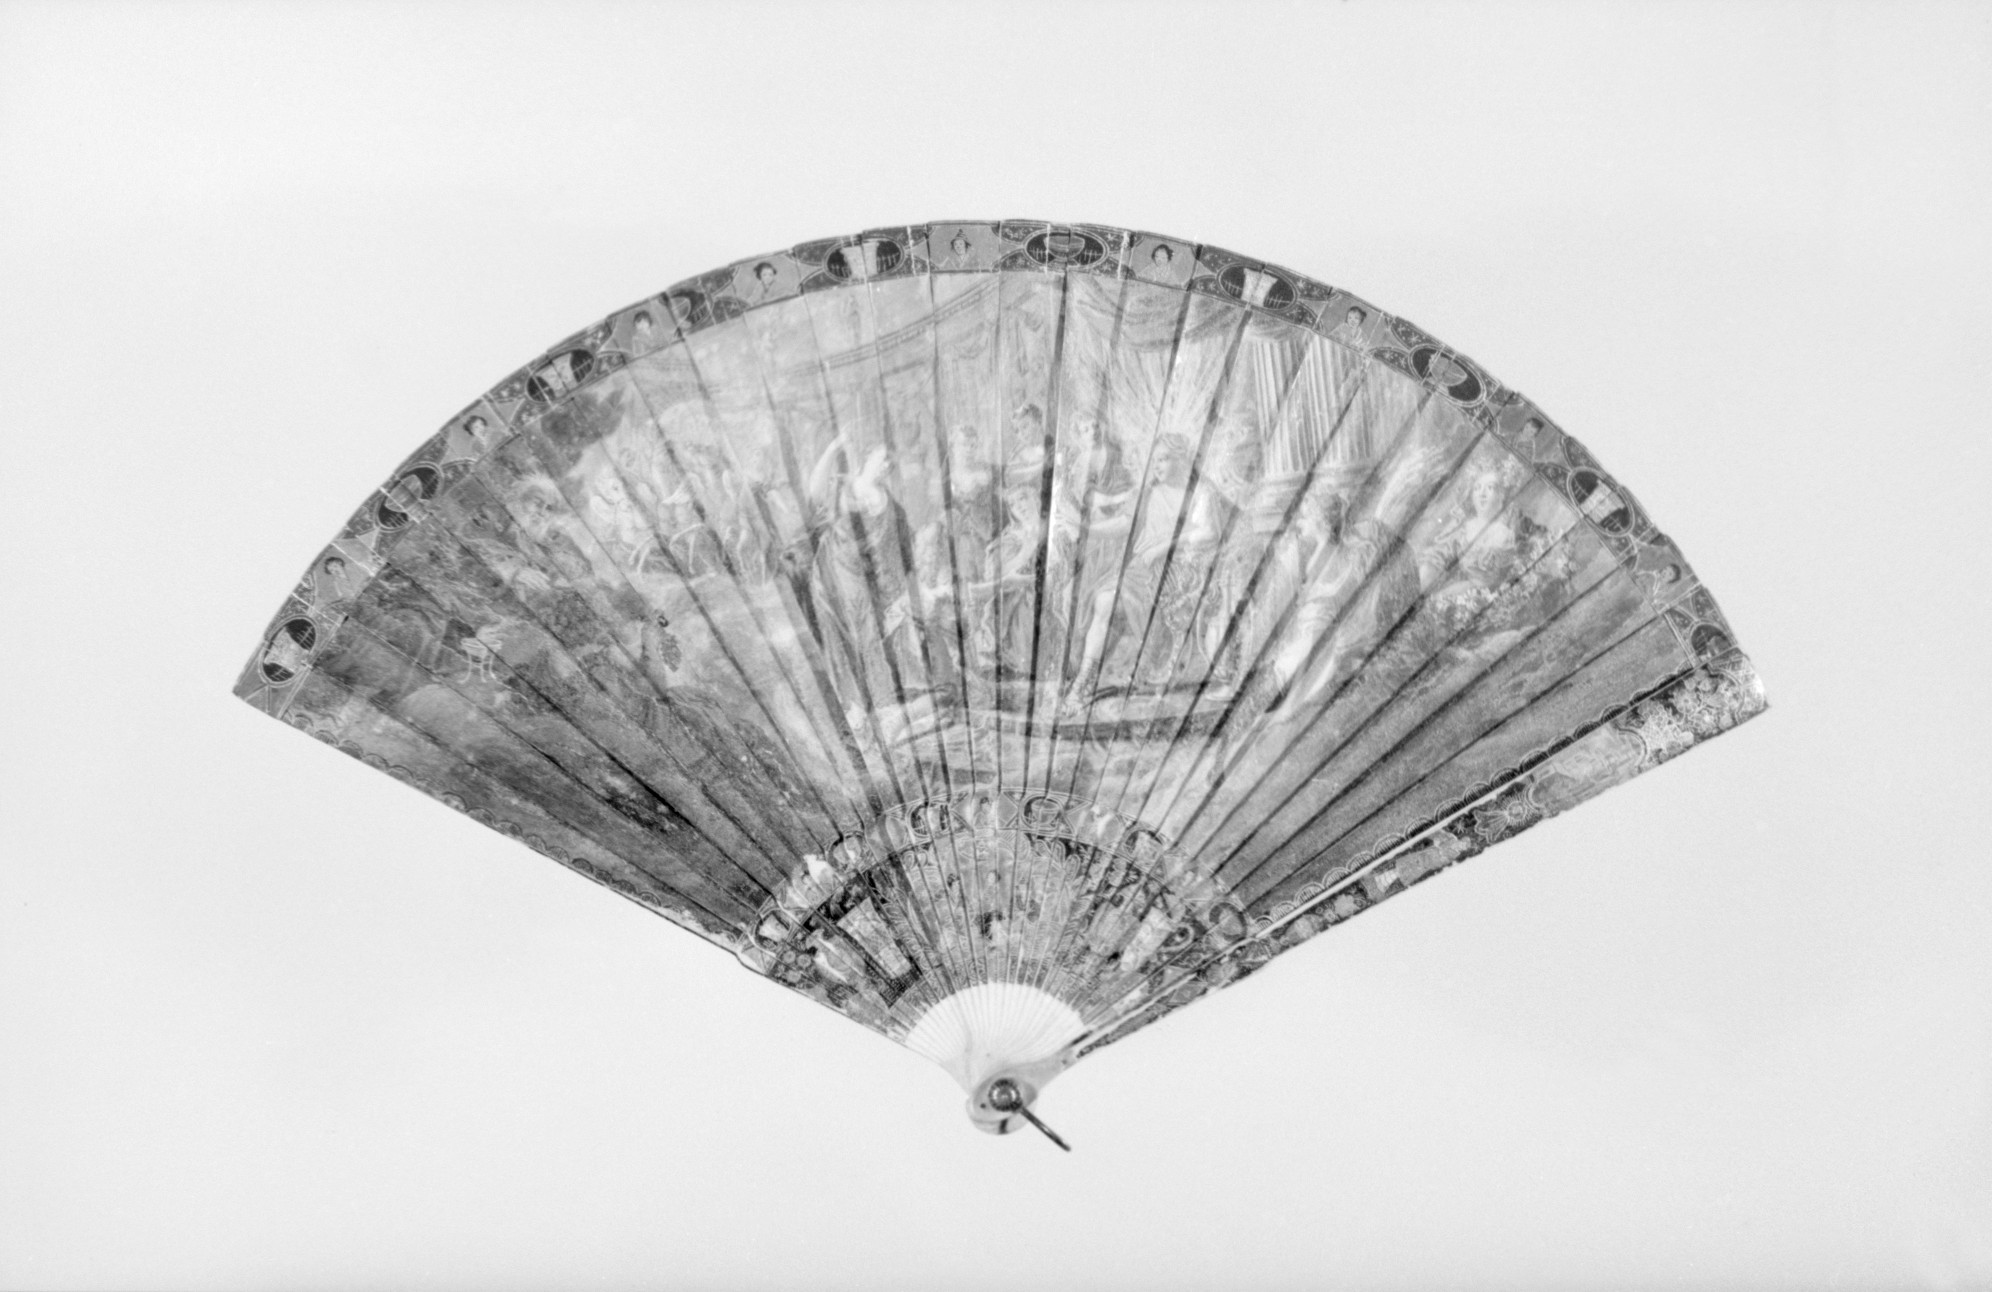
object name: fan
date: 1701-1800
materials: ivory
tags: men,women,ships